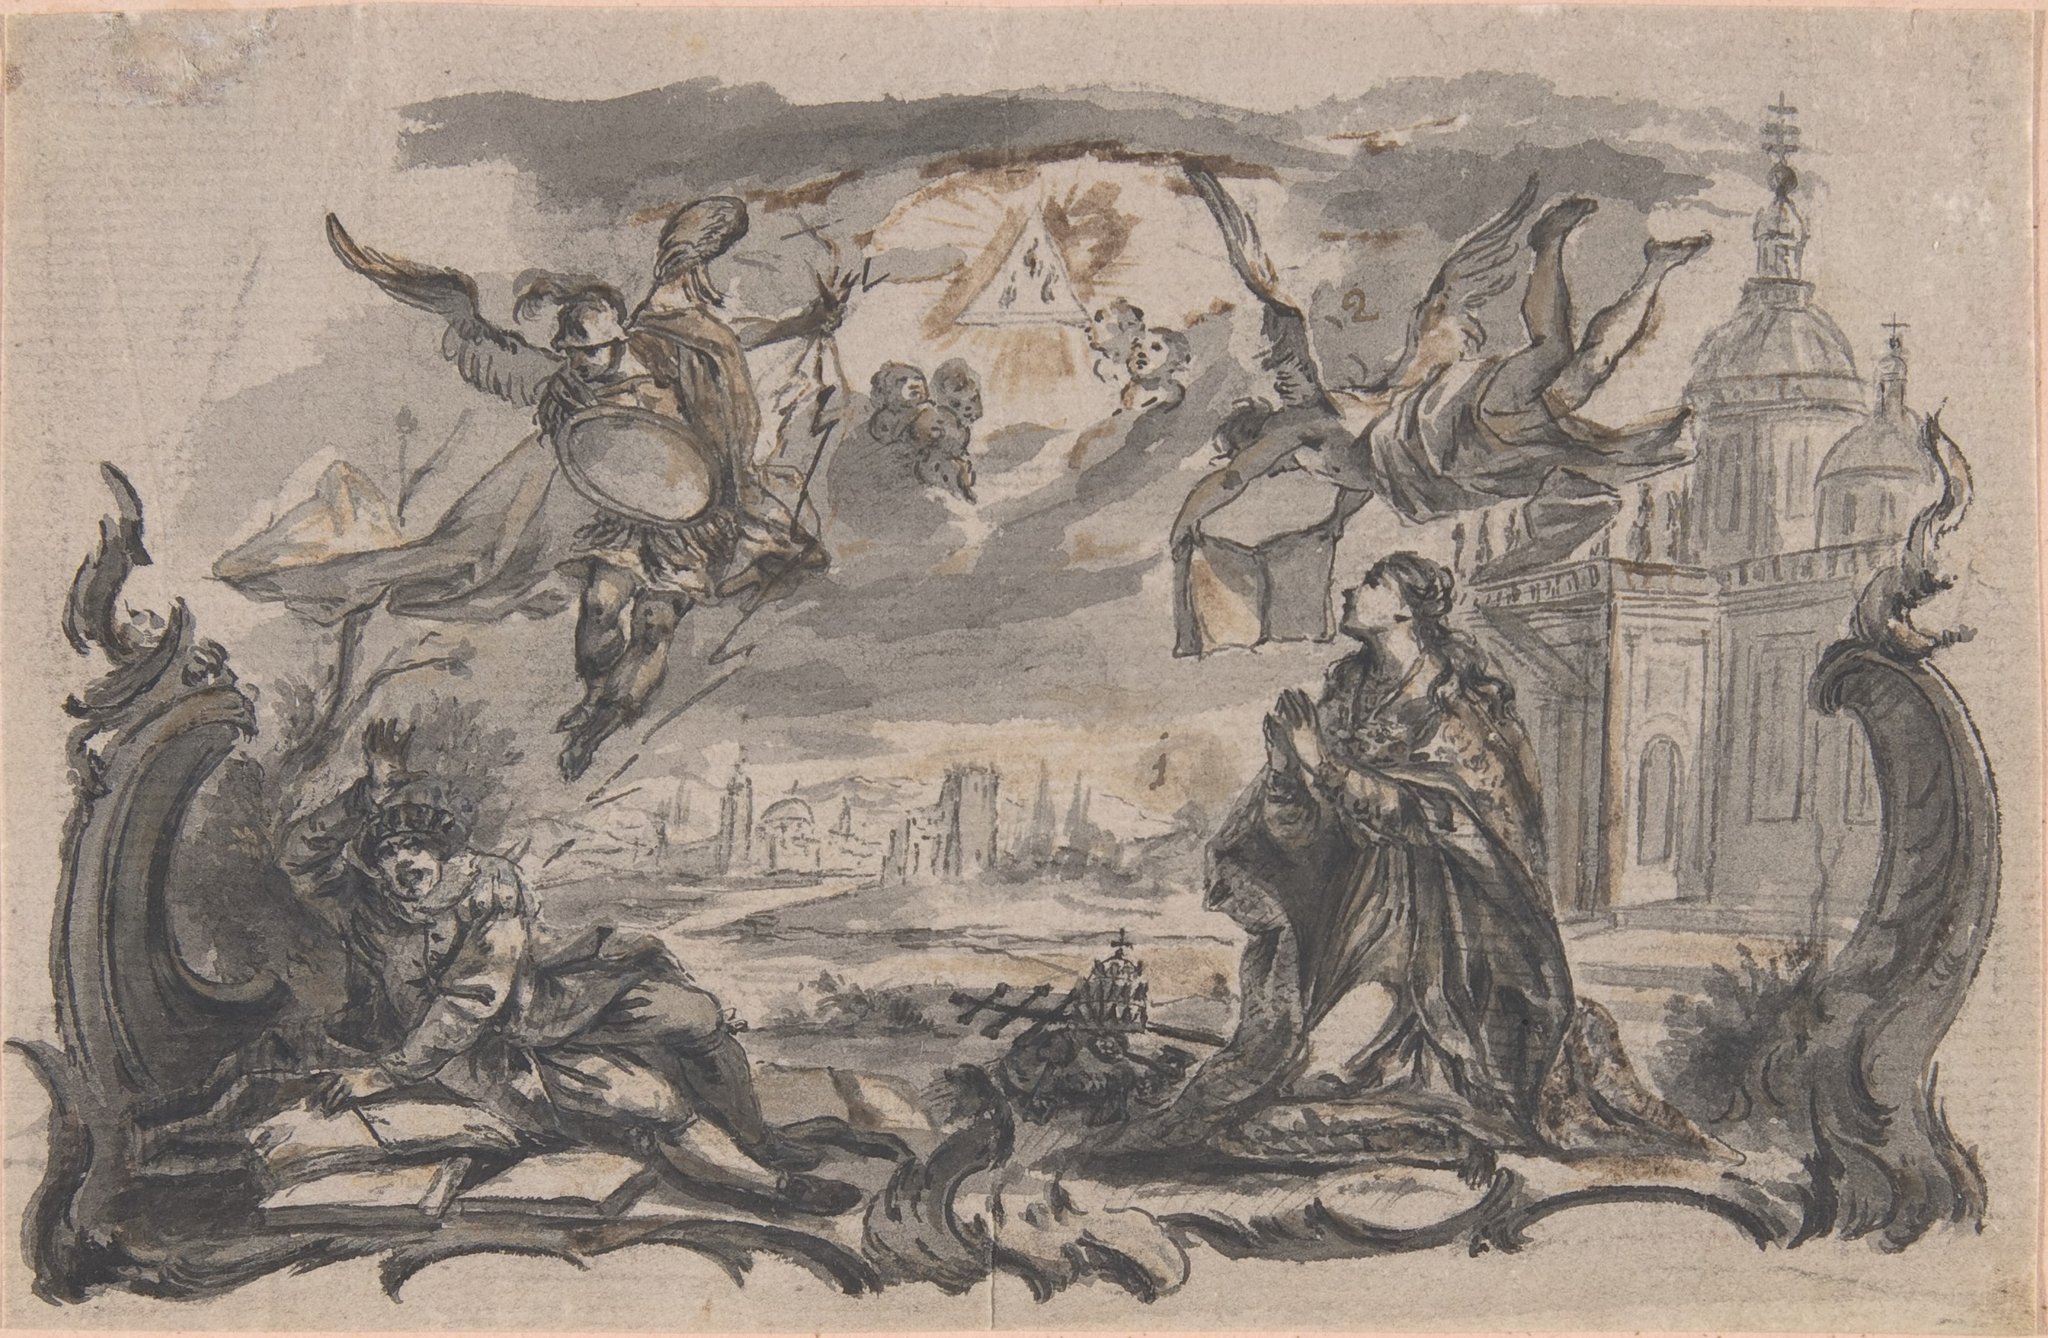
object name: drawing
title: Design for Book Illustration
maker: franz sigrist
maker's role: artist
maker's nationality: austrian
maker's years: 1727-1803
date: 1767-1800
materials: ink, paper, pencil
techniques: brush, incising, pen, transfer, wash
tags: men,women,angels